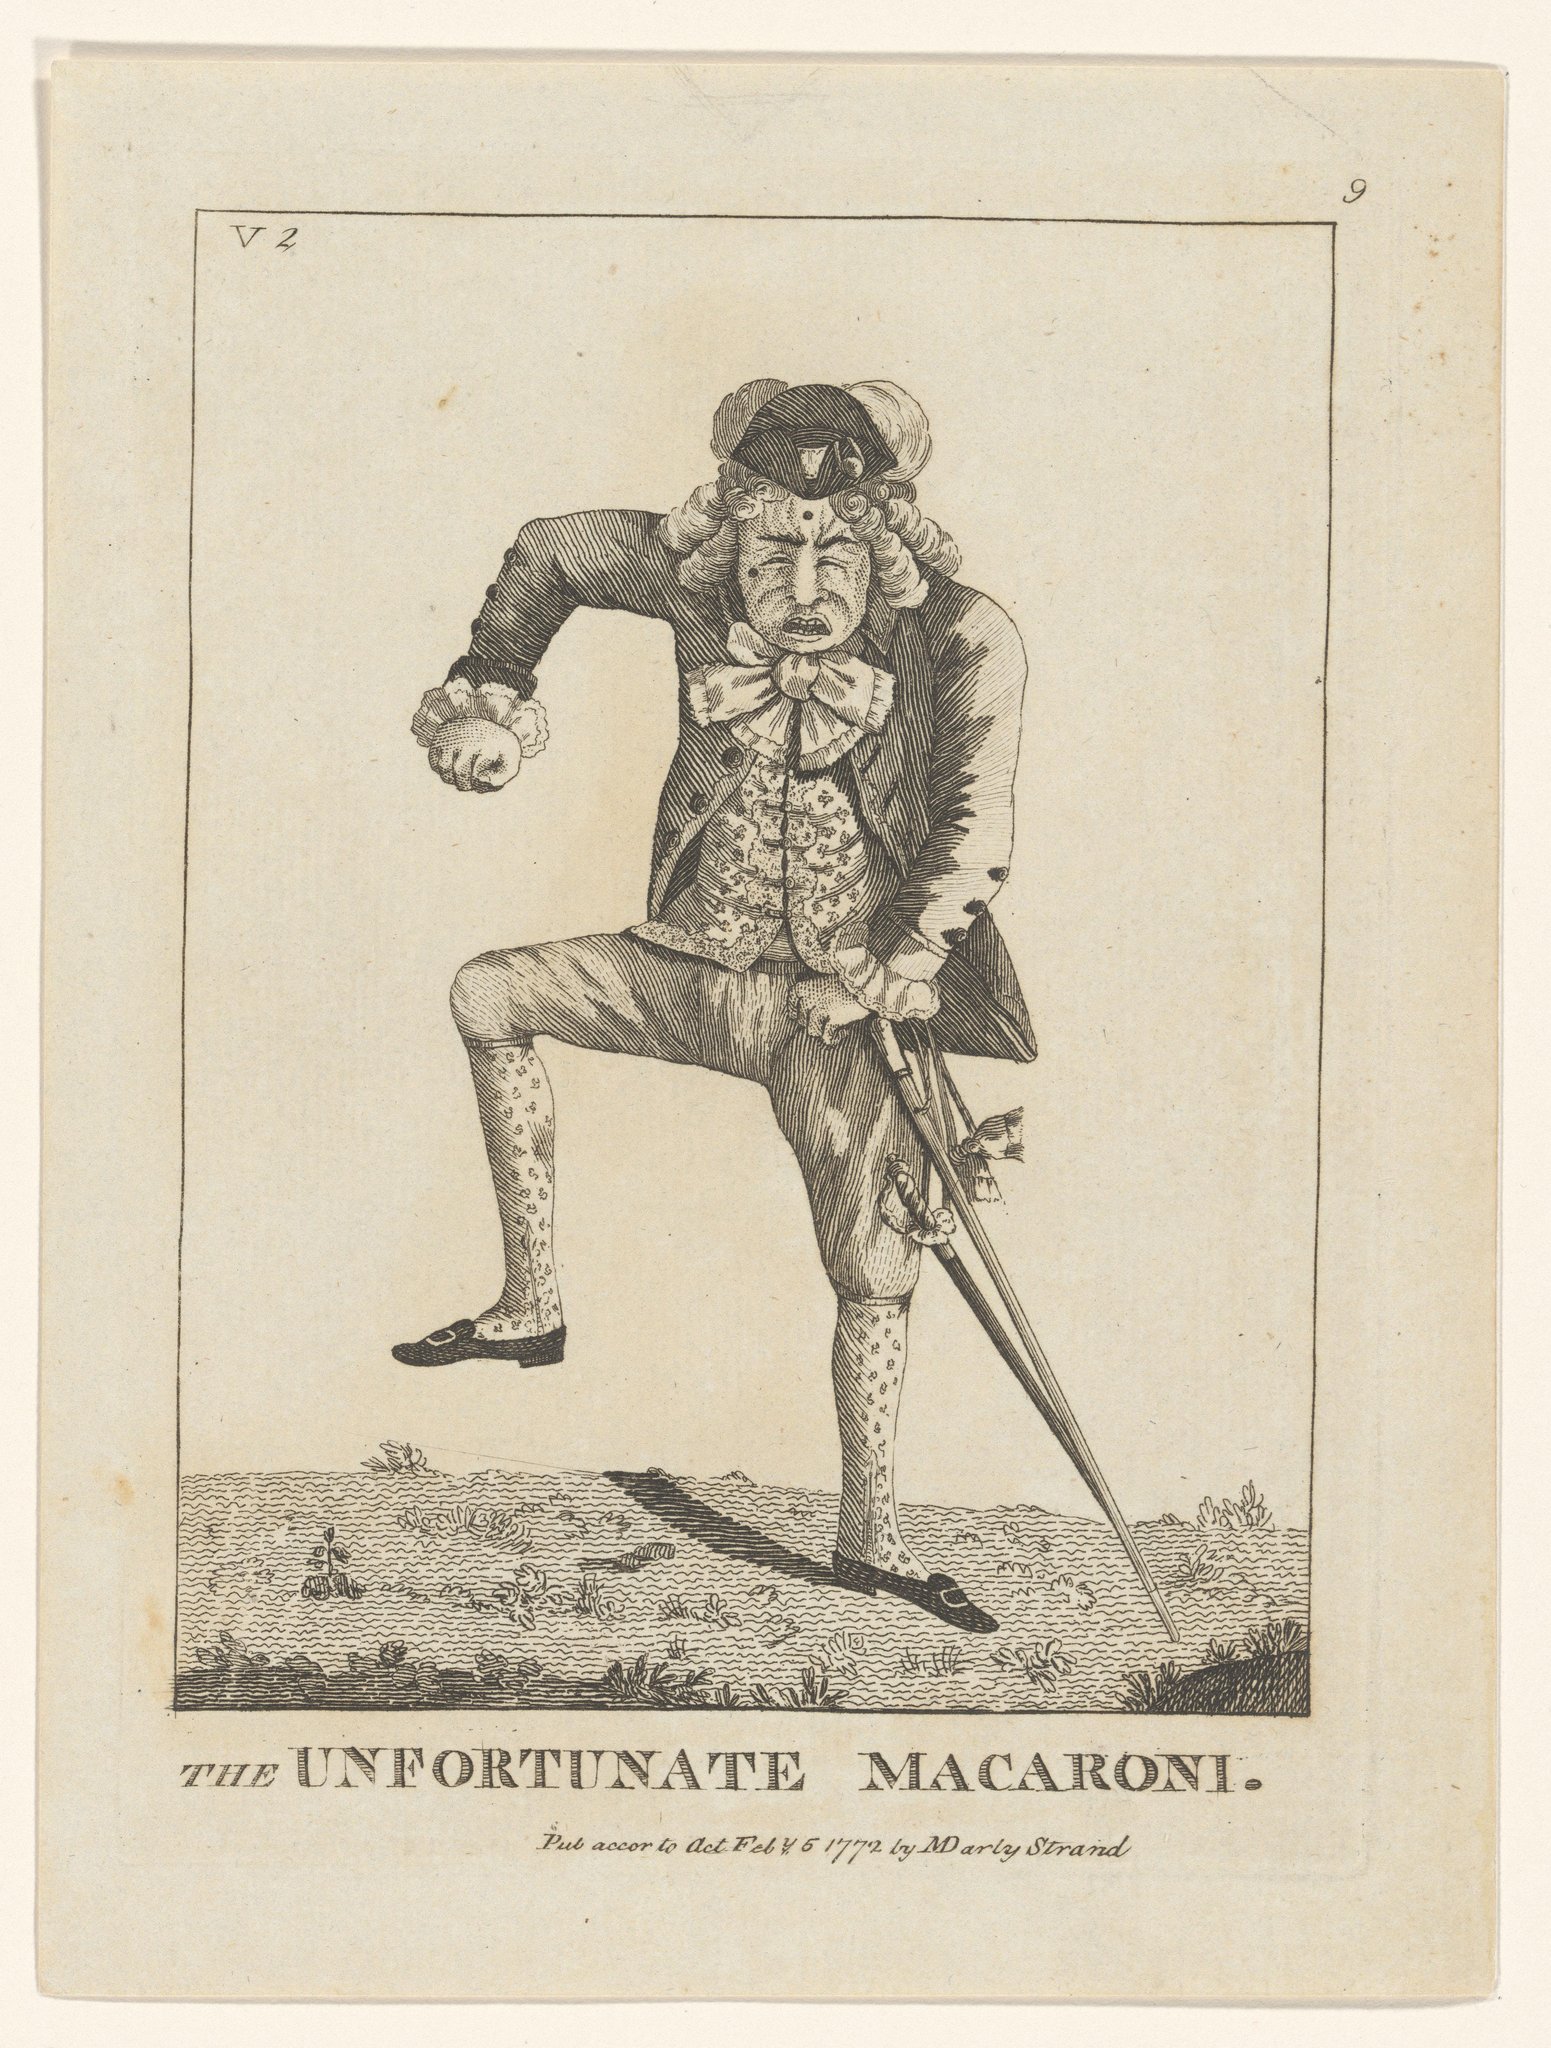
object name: cartoon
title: The Unfortunate Macaroni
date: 1772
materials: paper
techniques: etching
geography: london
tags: dandy, beau, caricatures (human types)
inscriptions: collector's mark: Lugt 2228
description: Een staande man gekleed volgens de laatste mode. Hij stampt van woede op de grond. Zijn rechter vuist is gebald. Prent nummer 9 uit de tweede van zes sets van elk 24 karikaturen van verschillende dames, heren, kunstenaars, enz., uitgegeven door de Darly’s.